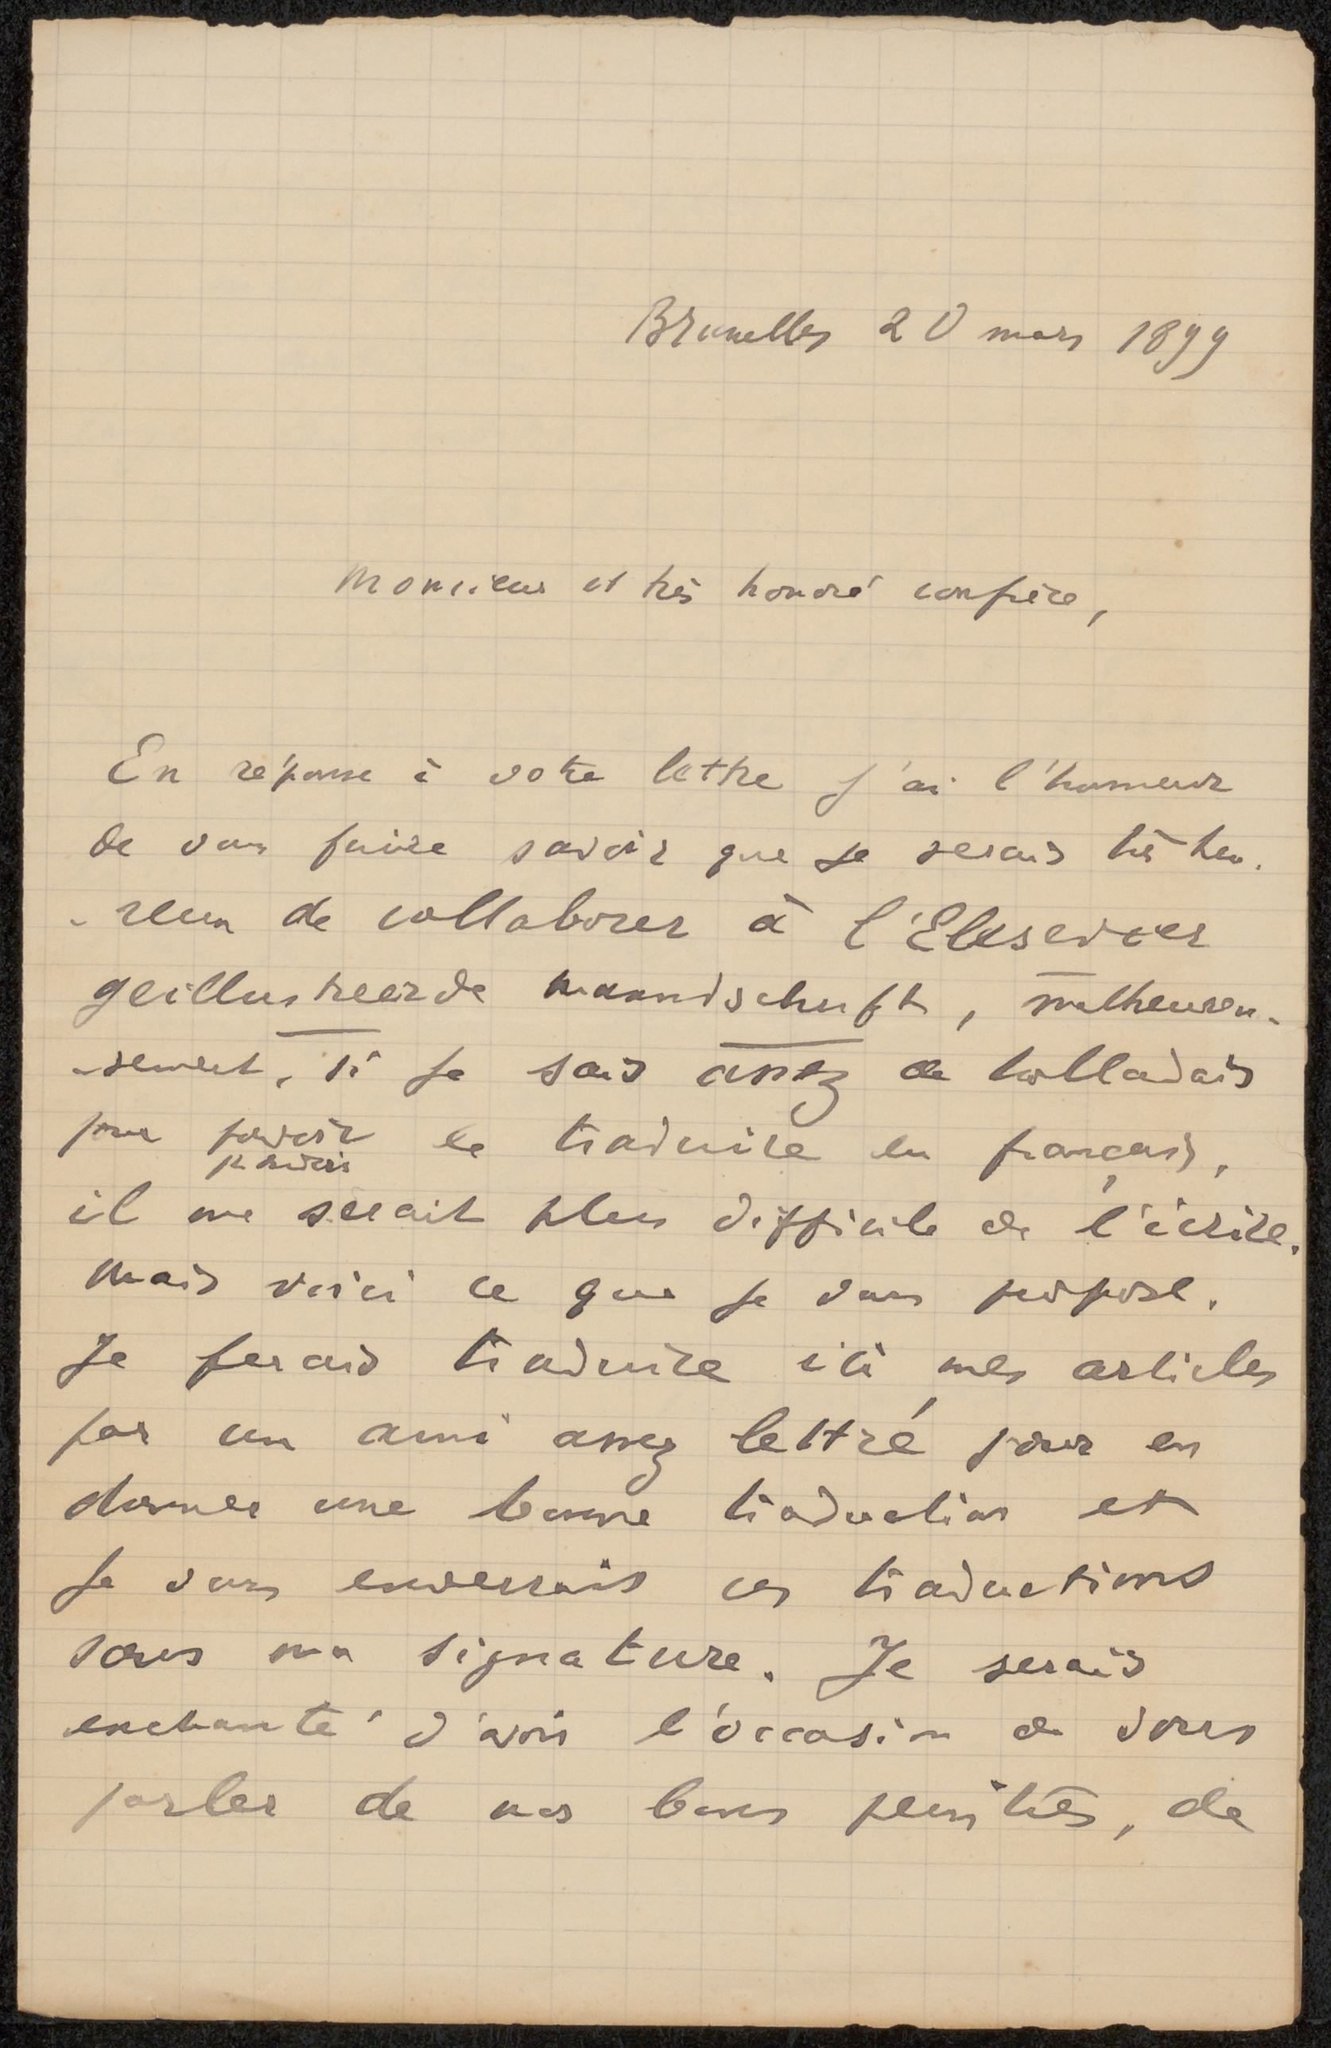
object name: letter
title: Brief aan Philip Zilcken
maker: georges eekhoud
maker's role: schrijver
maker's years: 1854-1927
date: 1899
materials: ink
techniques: pen, writing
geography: brussels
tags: brussels, print maker, hippolyte emmanuel boulenger, the hague, draughtsman, philip zilcken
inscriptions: collector's mark: ‘RPK’